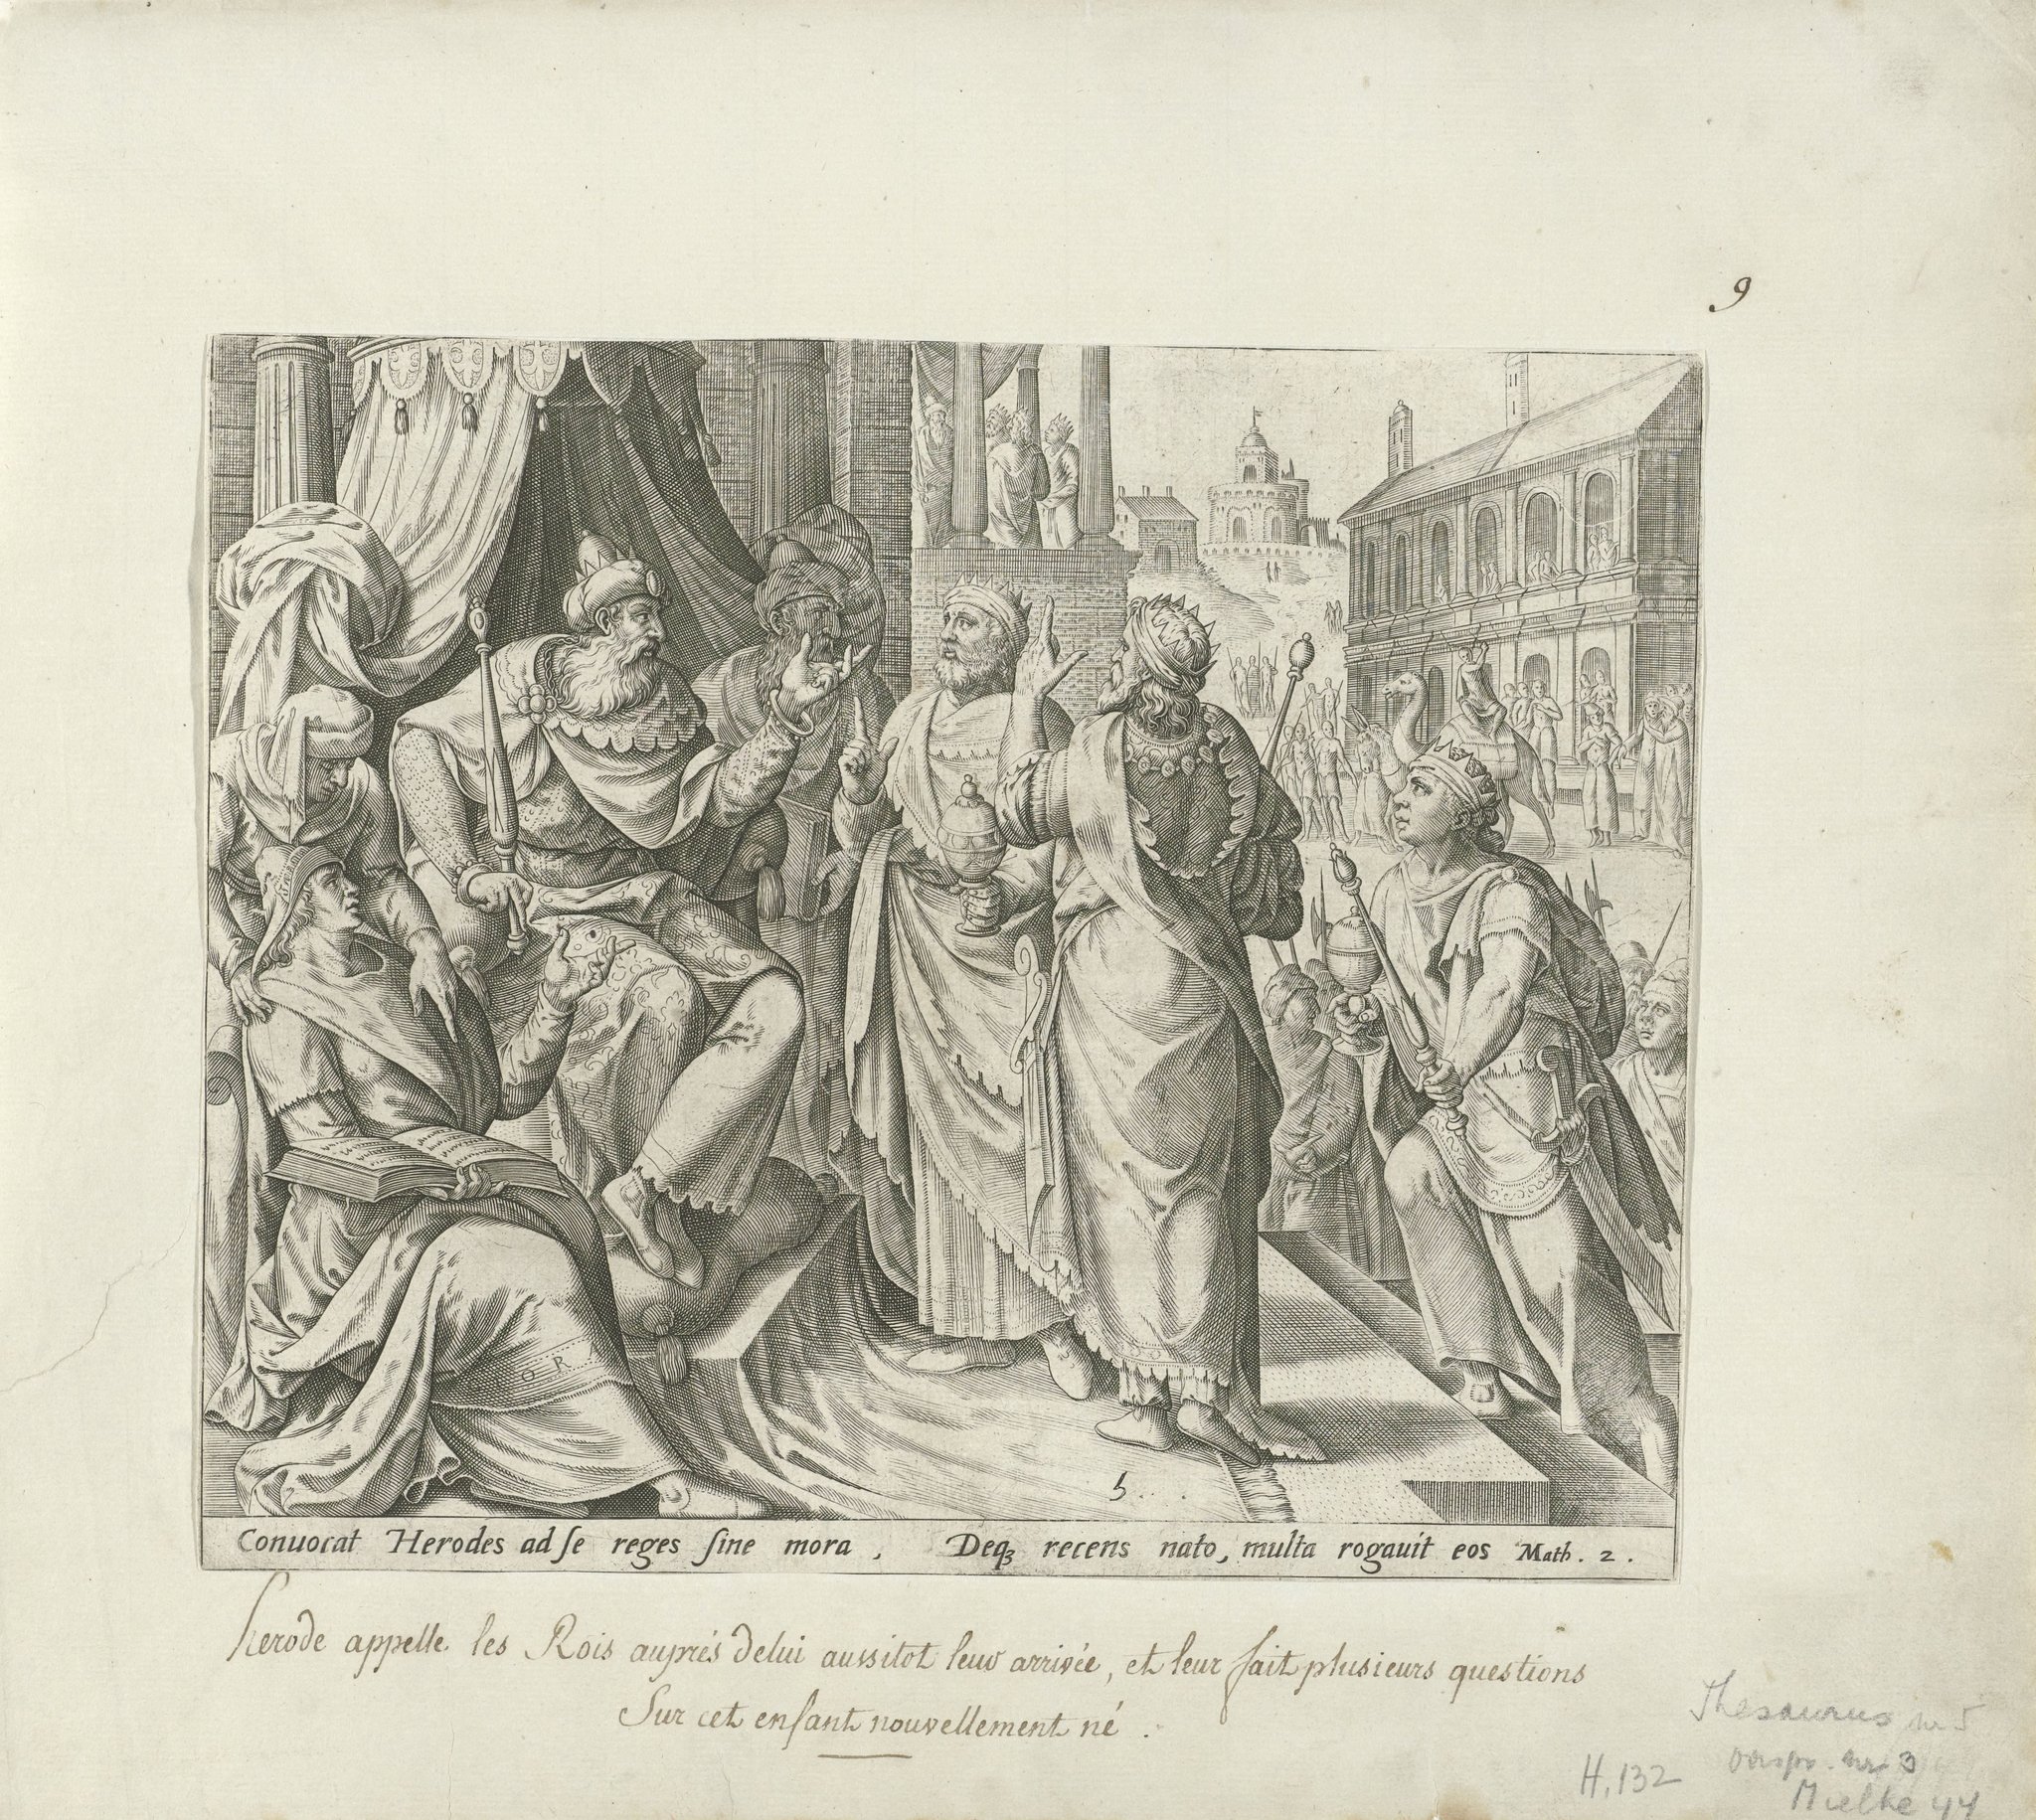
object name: print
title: Geboorte van Christus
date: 1585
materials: paper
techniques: engraving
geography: antwerp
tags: second visit of the three wise men to herod, first visit of the three wise men to king herod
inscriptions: number: ‘9’, caption: ‘Herode appelle les Rois auprès delui aussitot leur arrivée et leur fait plusieurs questions sur cet enfants nouvellement né’, collector's mark: Lugt 2228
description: De drie koningen bezoeken koning Herodes in Jeruzalem. Ze worden ondervraagd en krijgen van hem de opdracht terug te keren na hun bezoek aan het Christuskind en verslag te doen over diens geboorte. De prent heeft een Latijns onderschrift met een Bijbeltekst.